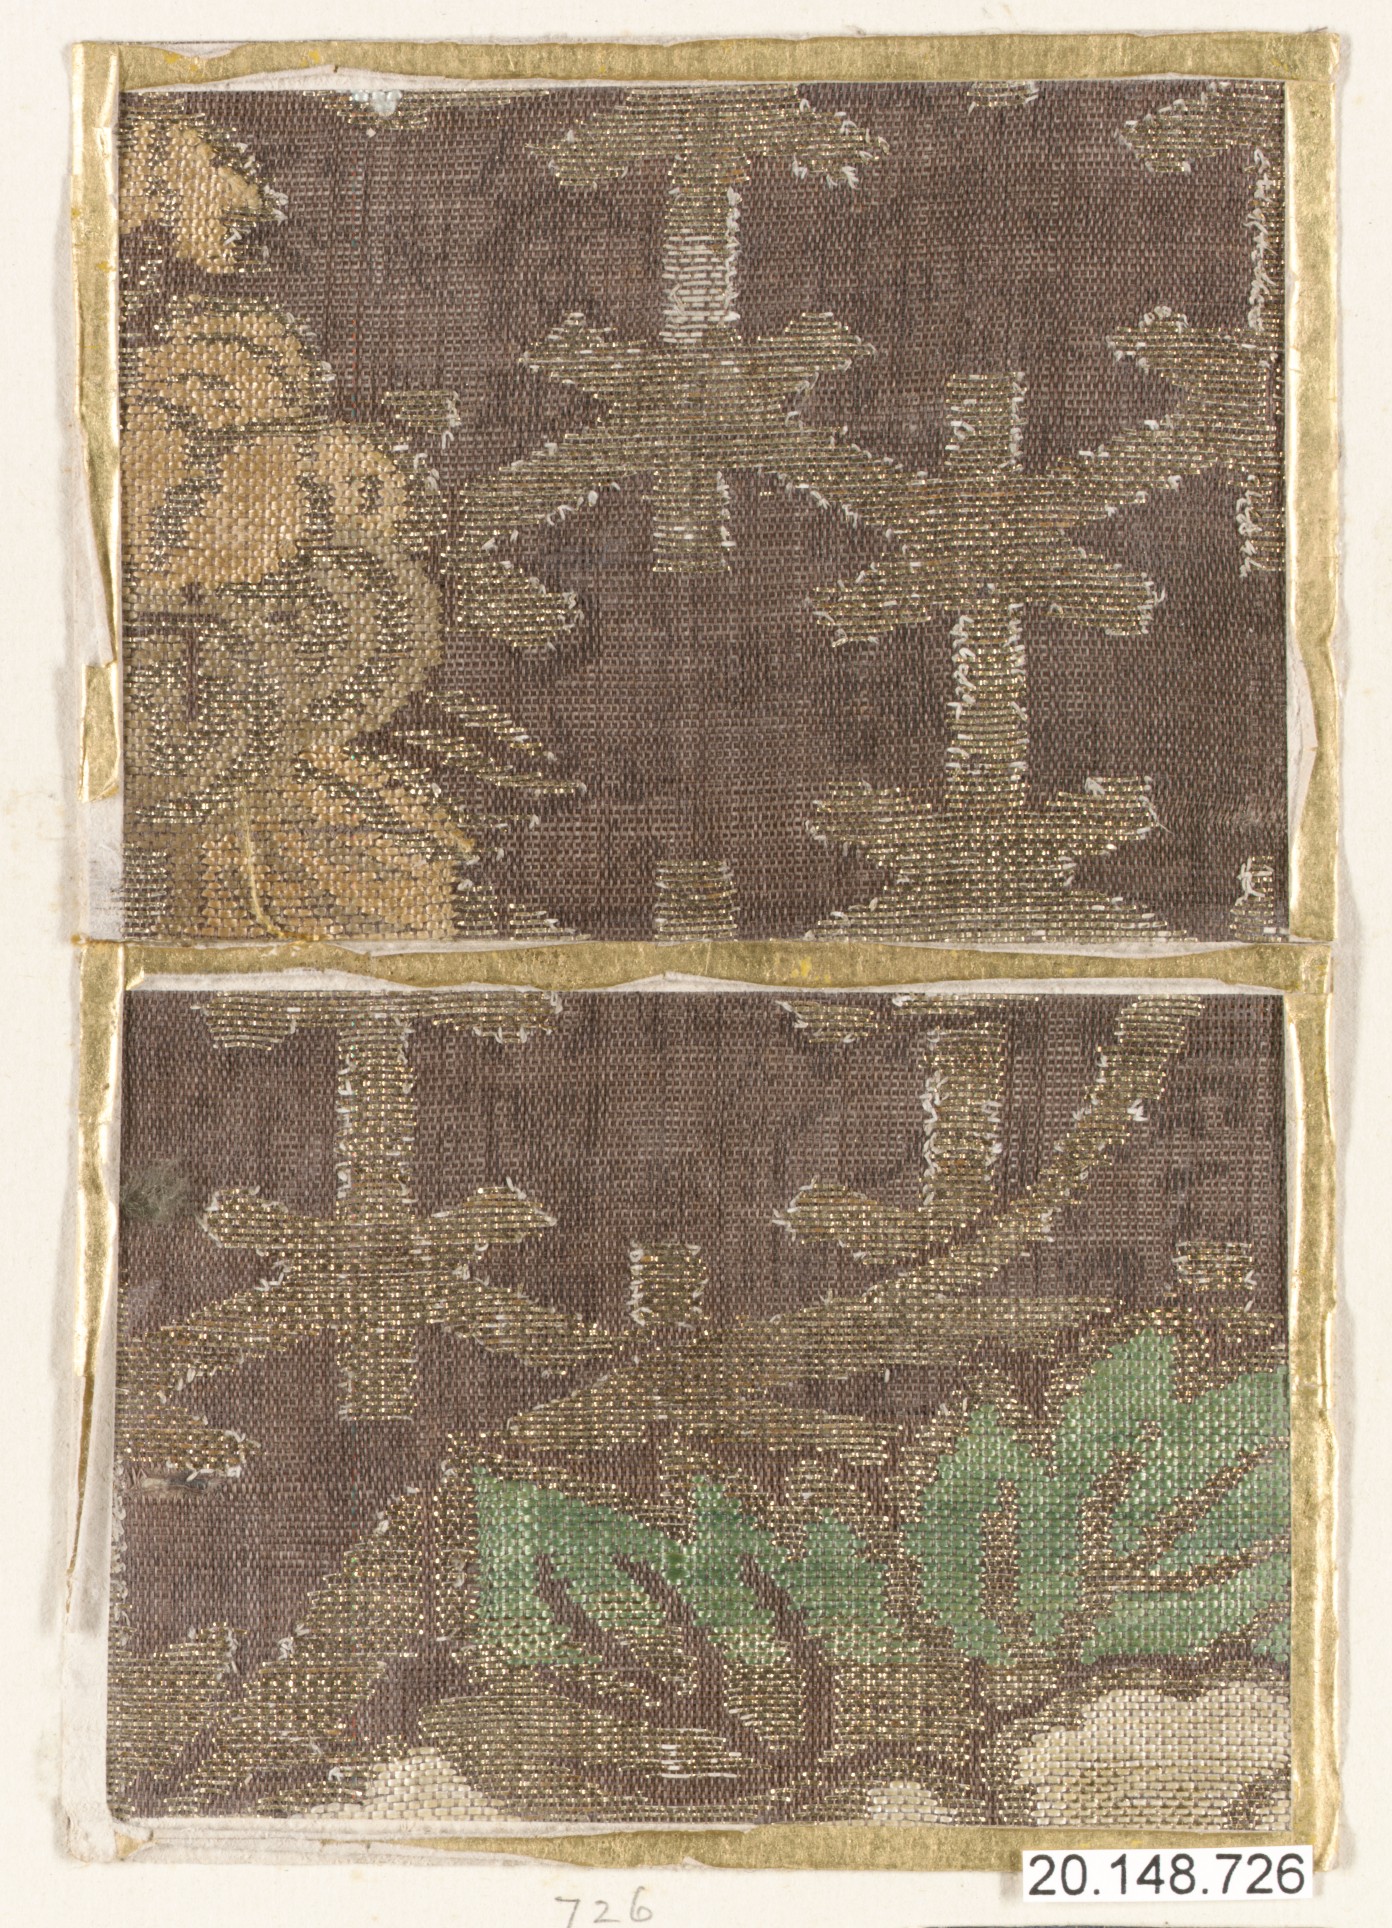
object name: piece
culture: china or japan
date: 1601-1700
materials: silk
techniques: compound weave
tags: leaves